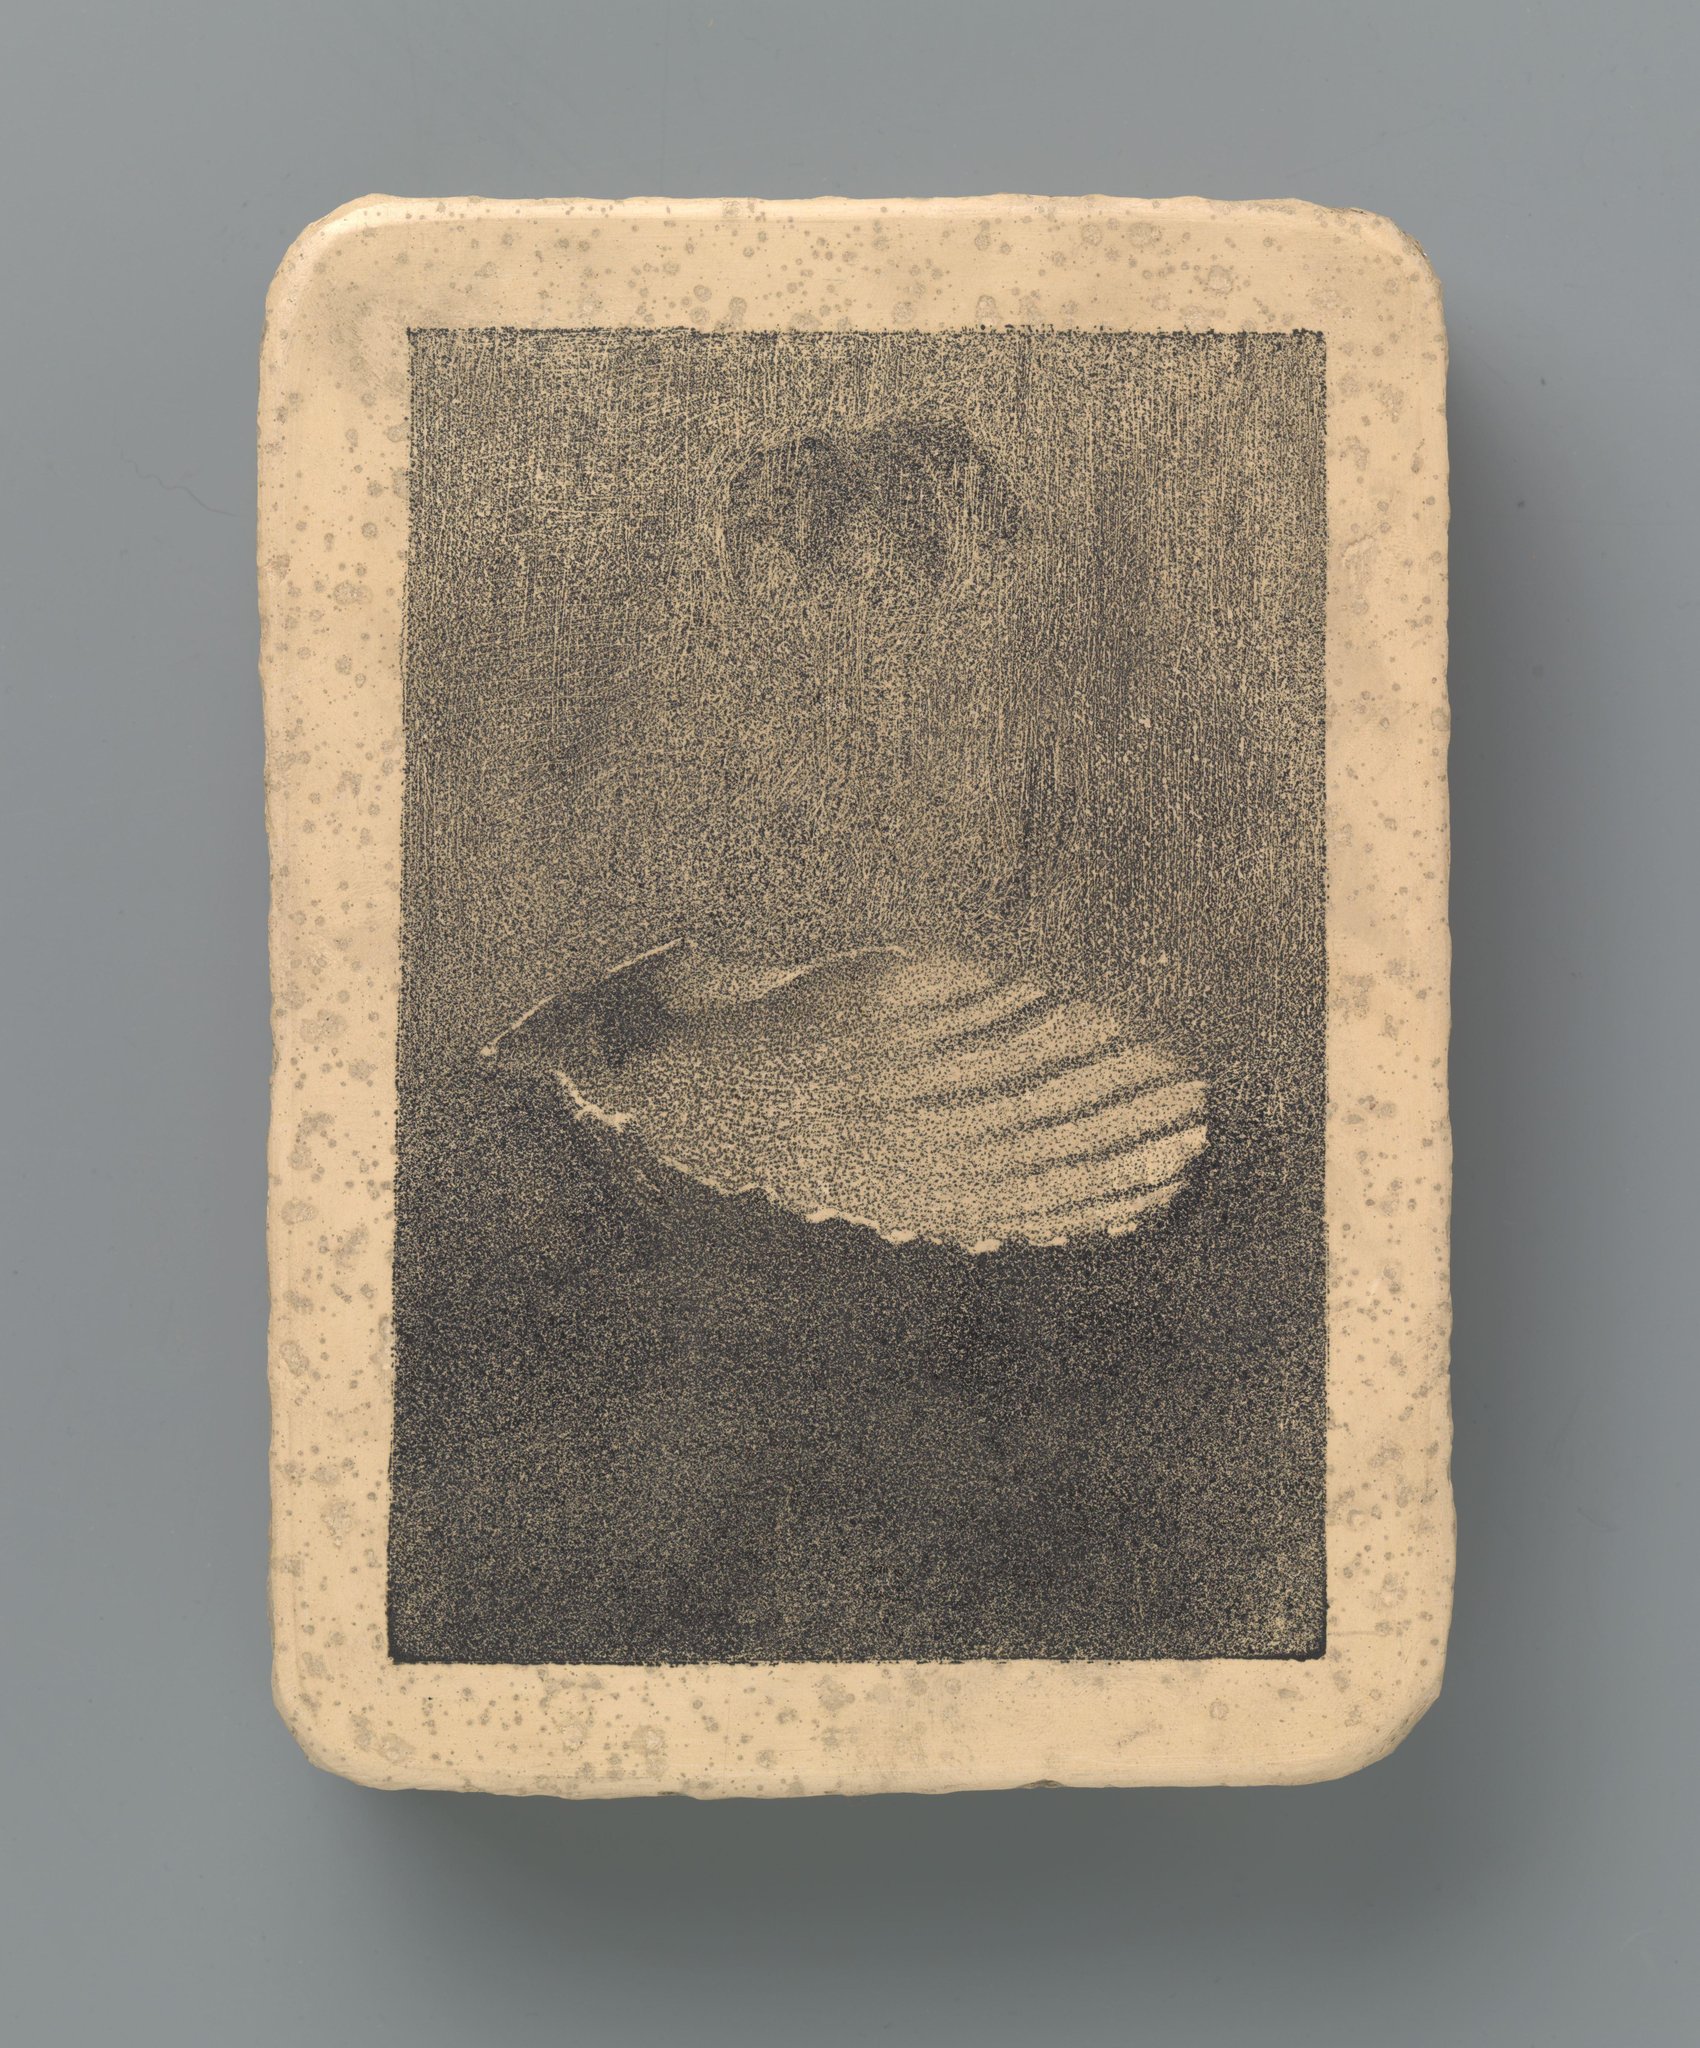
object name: lithographic stone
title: Schelp op tafel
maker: julie de graag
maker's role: draughtsman, print maker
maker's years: 1877-1924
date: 1887-1924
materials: stone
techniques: lithograph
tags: molluscs (+ shell, snail-shell etc.)